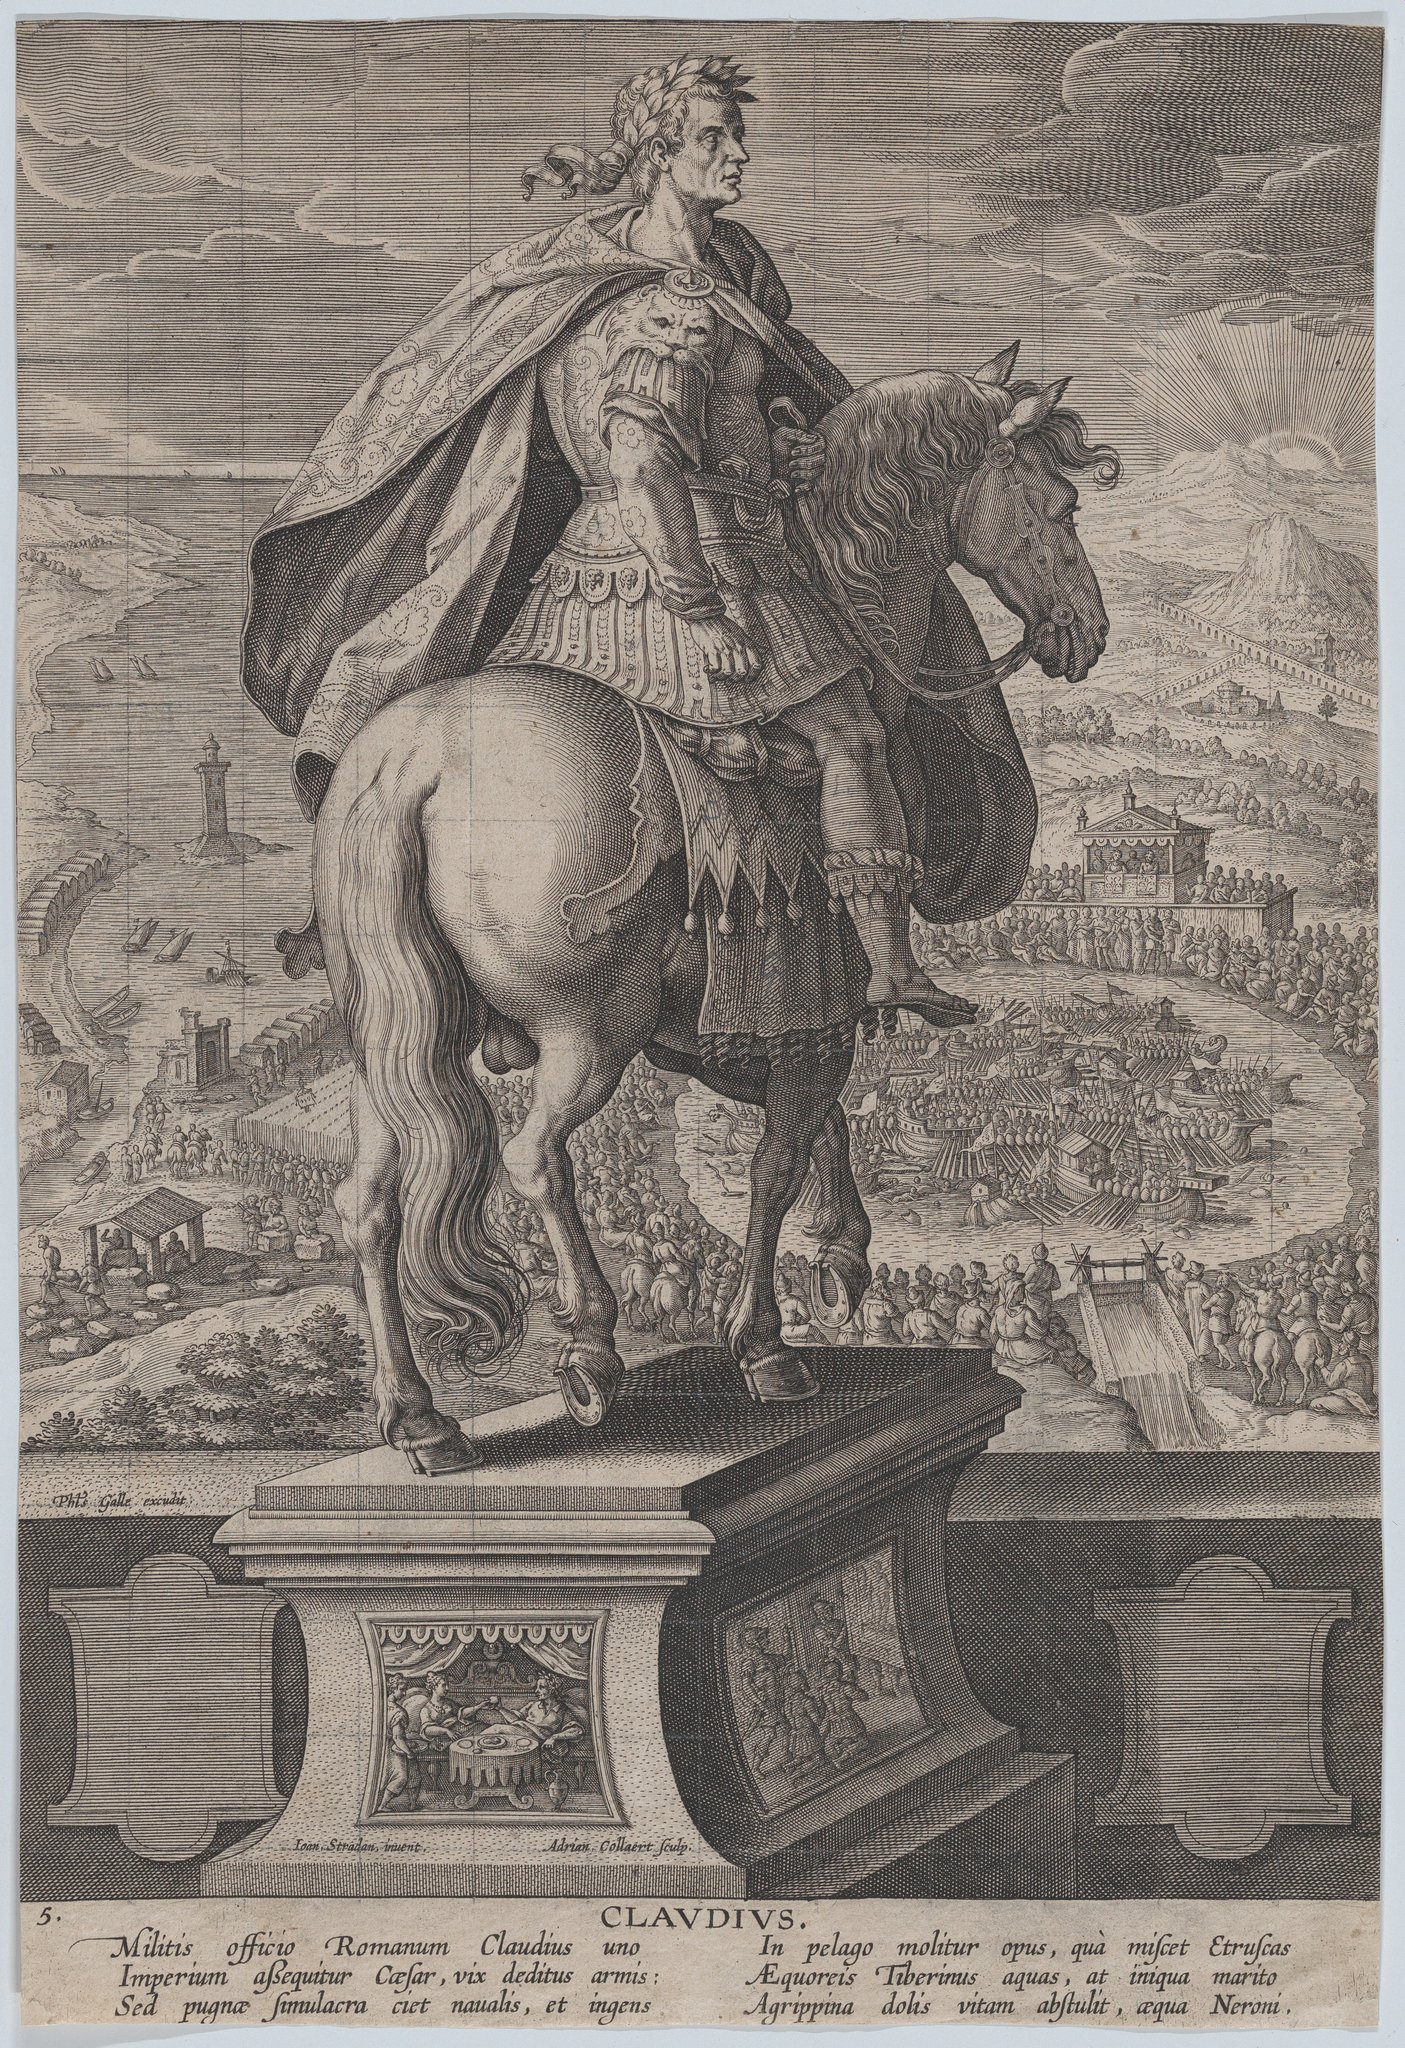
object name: print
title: Plate 5: equestrian statue of Claudius, seen from behind, a naval competition at right in the background, from 'Roman Emperors on Horseback'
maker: adriaen collaert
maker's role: artist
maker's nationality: netherlandish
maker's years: 1560-1618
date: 1587-1589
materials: graphite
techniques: engraving, drawing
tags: monuments,horses